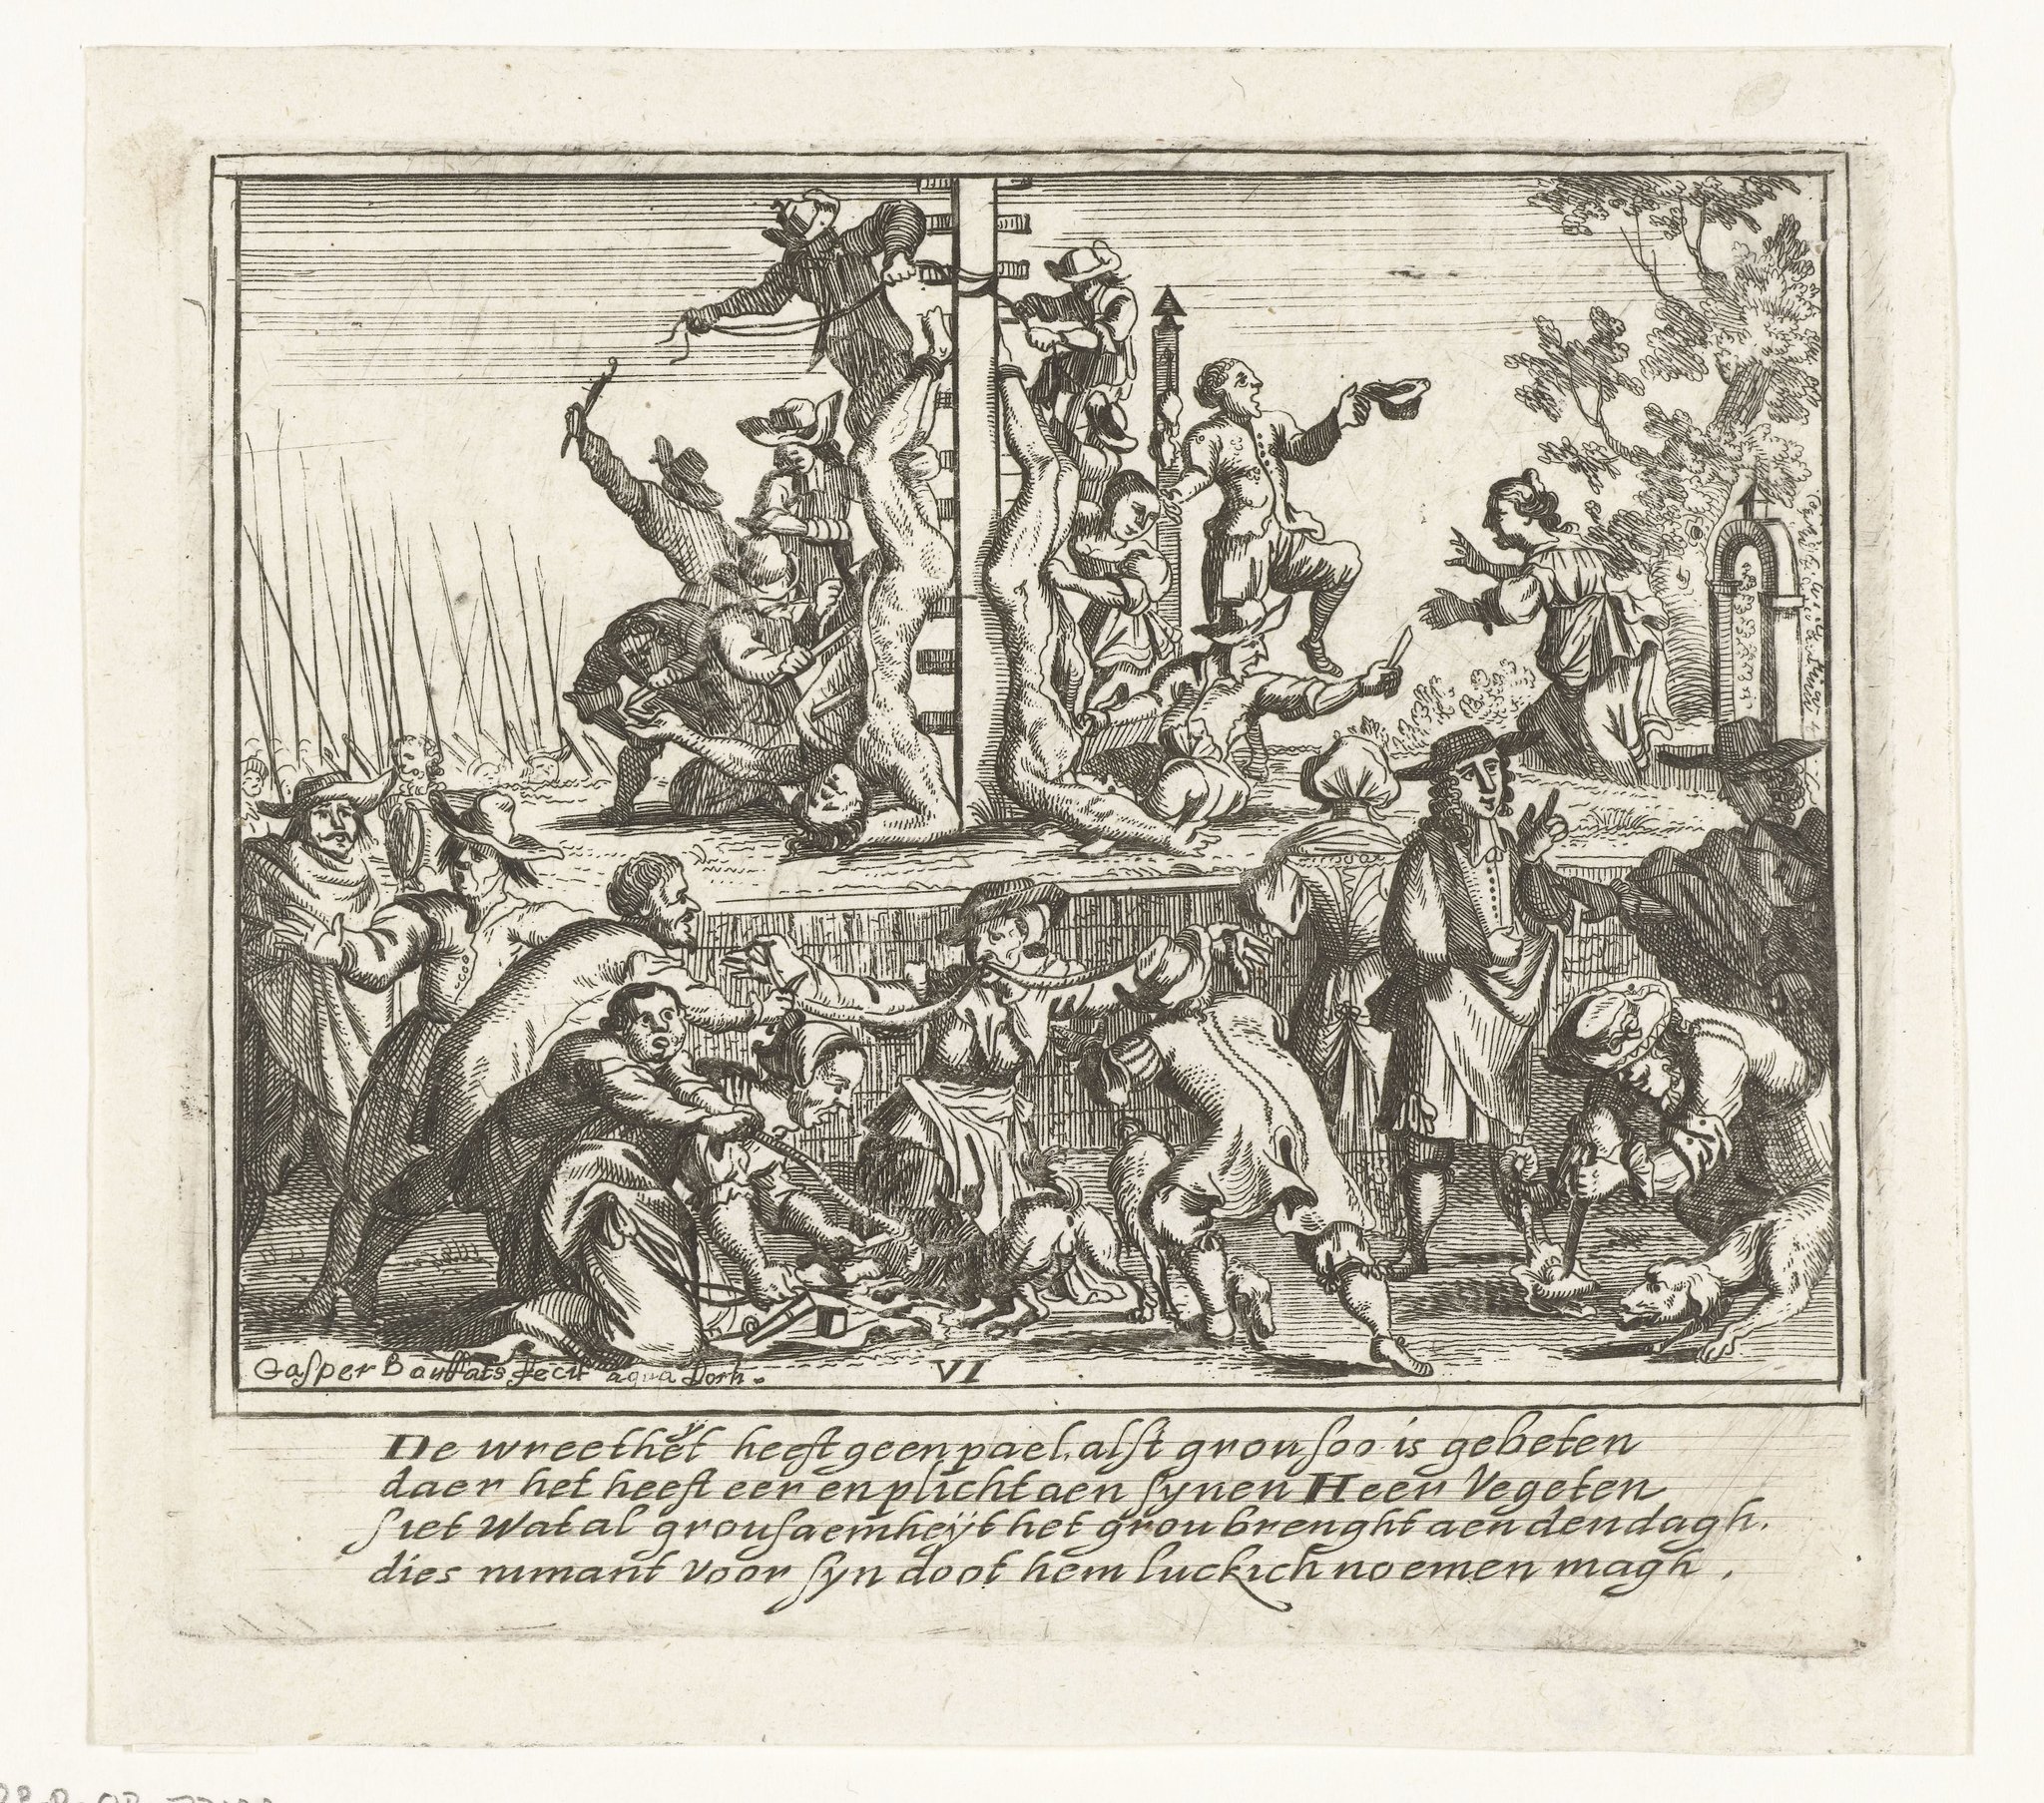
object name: print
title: Acht voorstellingen uit het leven van de gebroeders De Witt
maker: gaspar bouttats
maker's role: print maker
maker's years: 1640-1695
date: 1672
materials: paper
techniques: etching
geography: antwerp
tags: dordrecht, cornelis de witt, the hague, politician, johan de witt, mutilation of the corpse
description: Zesde prent in een reeks van acht voorstellingen over het leven van Johan en Cornelis de Witt. Alle prenten zijn van de hand van Gaspar Bouttats en hebben een vers van vier of twee regels. De voorstelling toont het verminken van de lichamen van de gebroeders de Witt door de burgers van Den Haag, 20 augustus 1672.